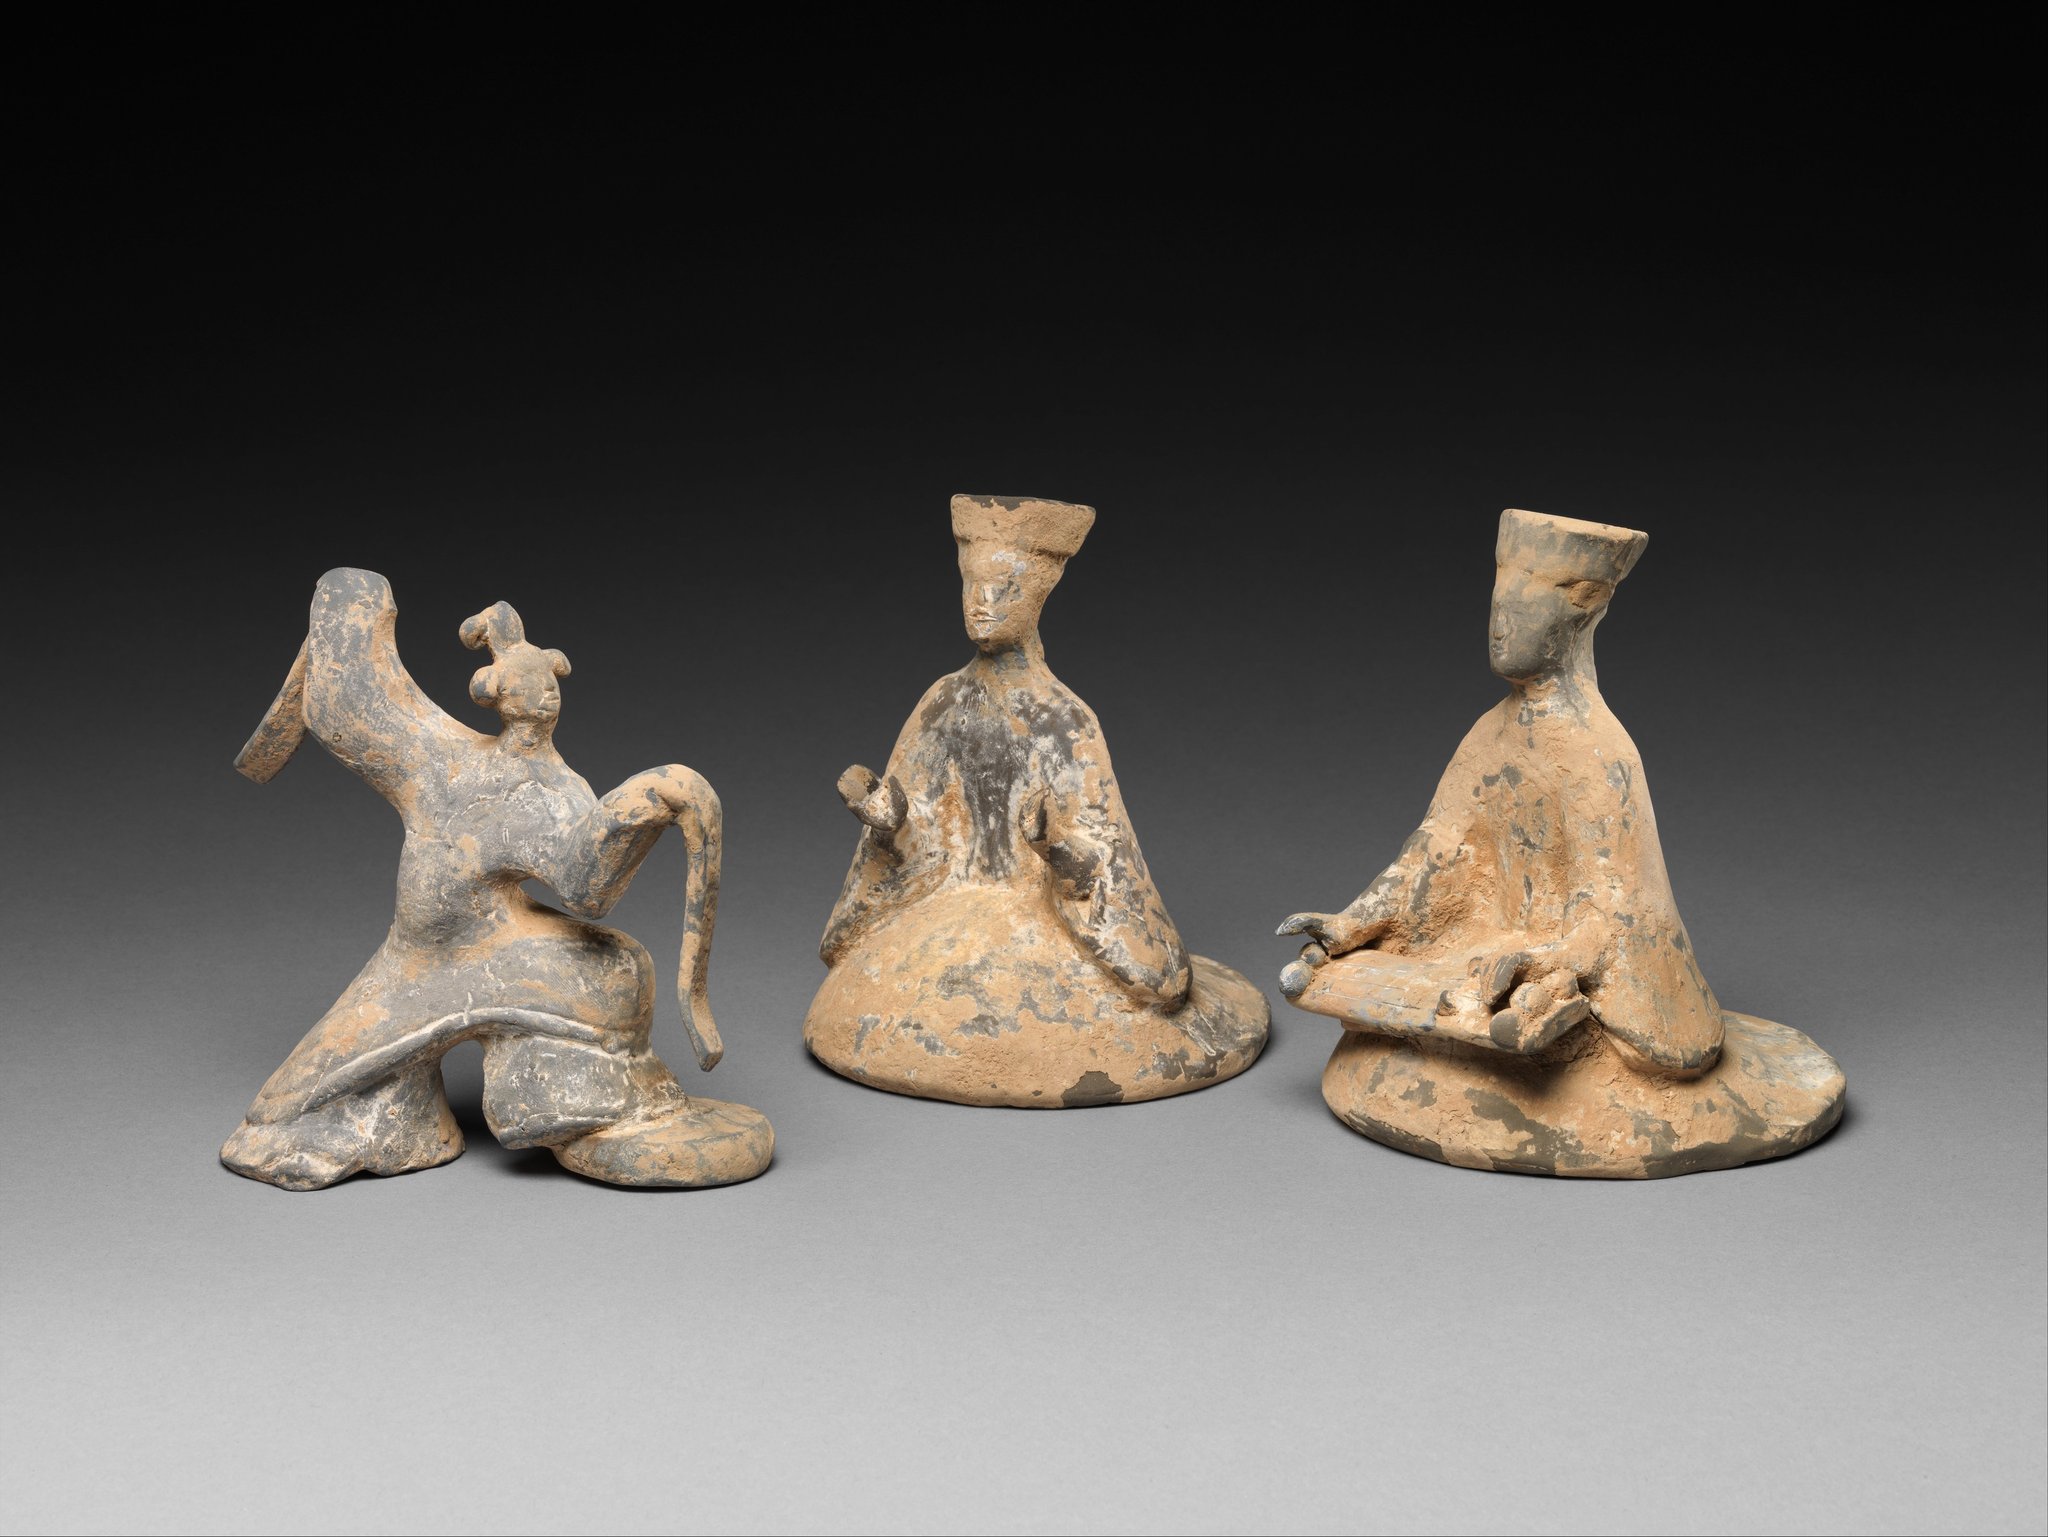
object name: figure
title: Dancer and Musicians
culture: chinese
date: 100 BCE-100 CE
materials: earthenware, pigment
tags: human figures,women,dancers,musicians